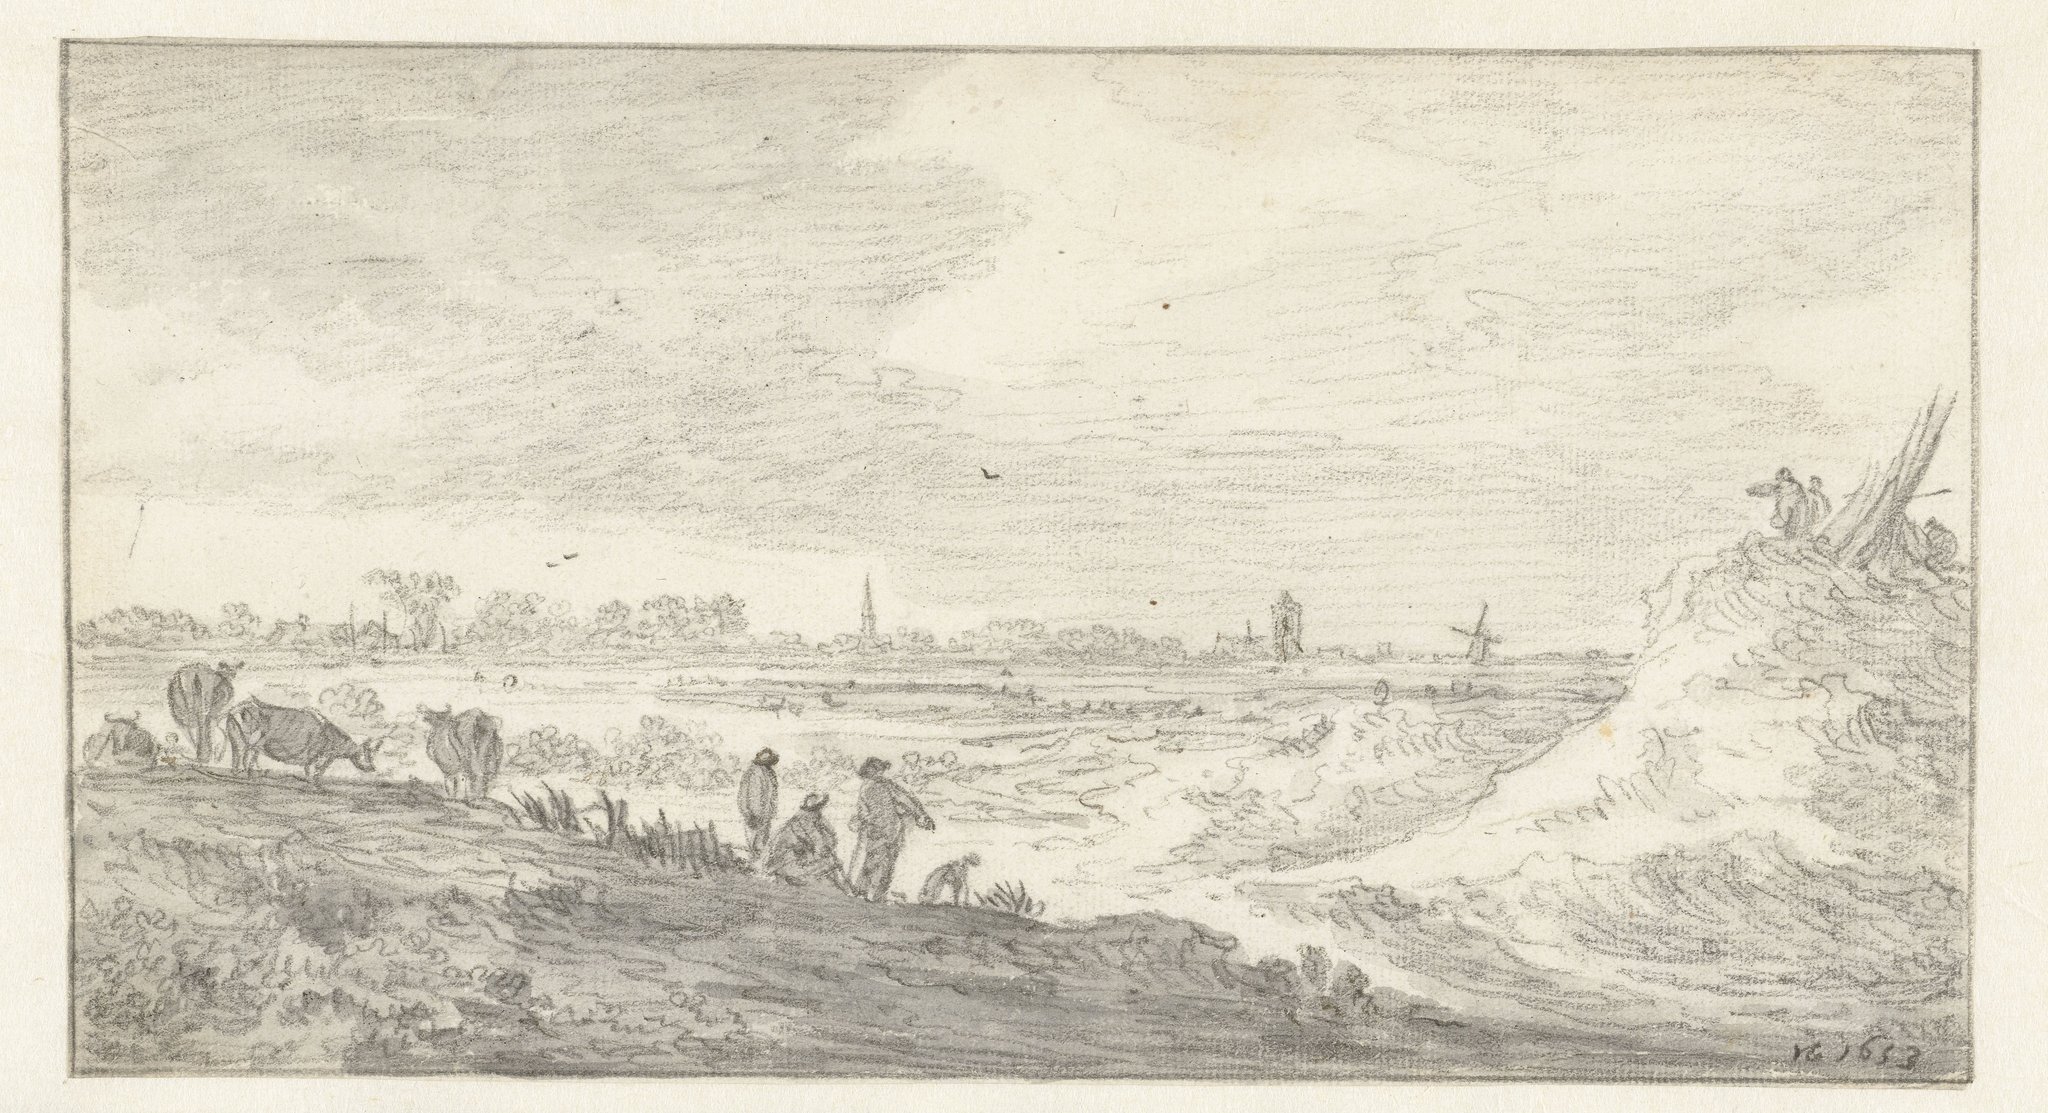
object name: drawing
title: Landschap met figuren op een duin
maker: jan van goyen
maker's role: draughtsman, painter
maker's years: 1596-1656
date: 1653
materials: chalk, paper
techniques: brush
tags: cultivated land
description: Landschap met figuren op een hoge duin en links koeien.